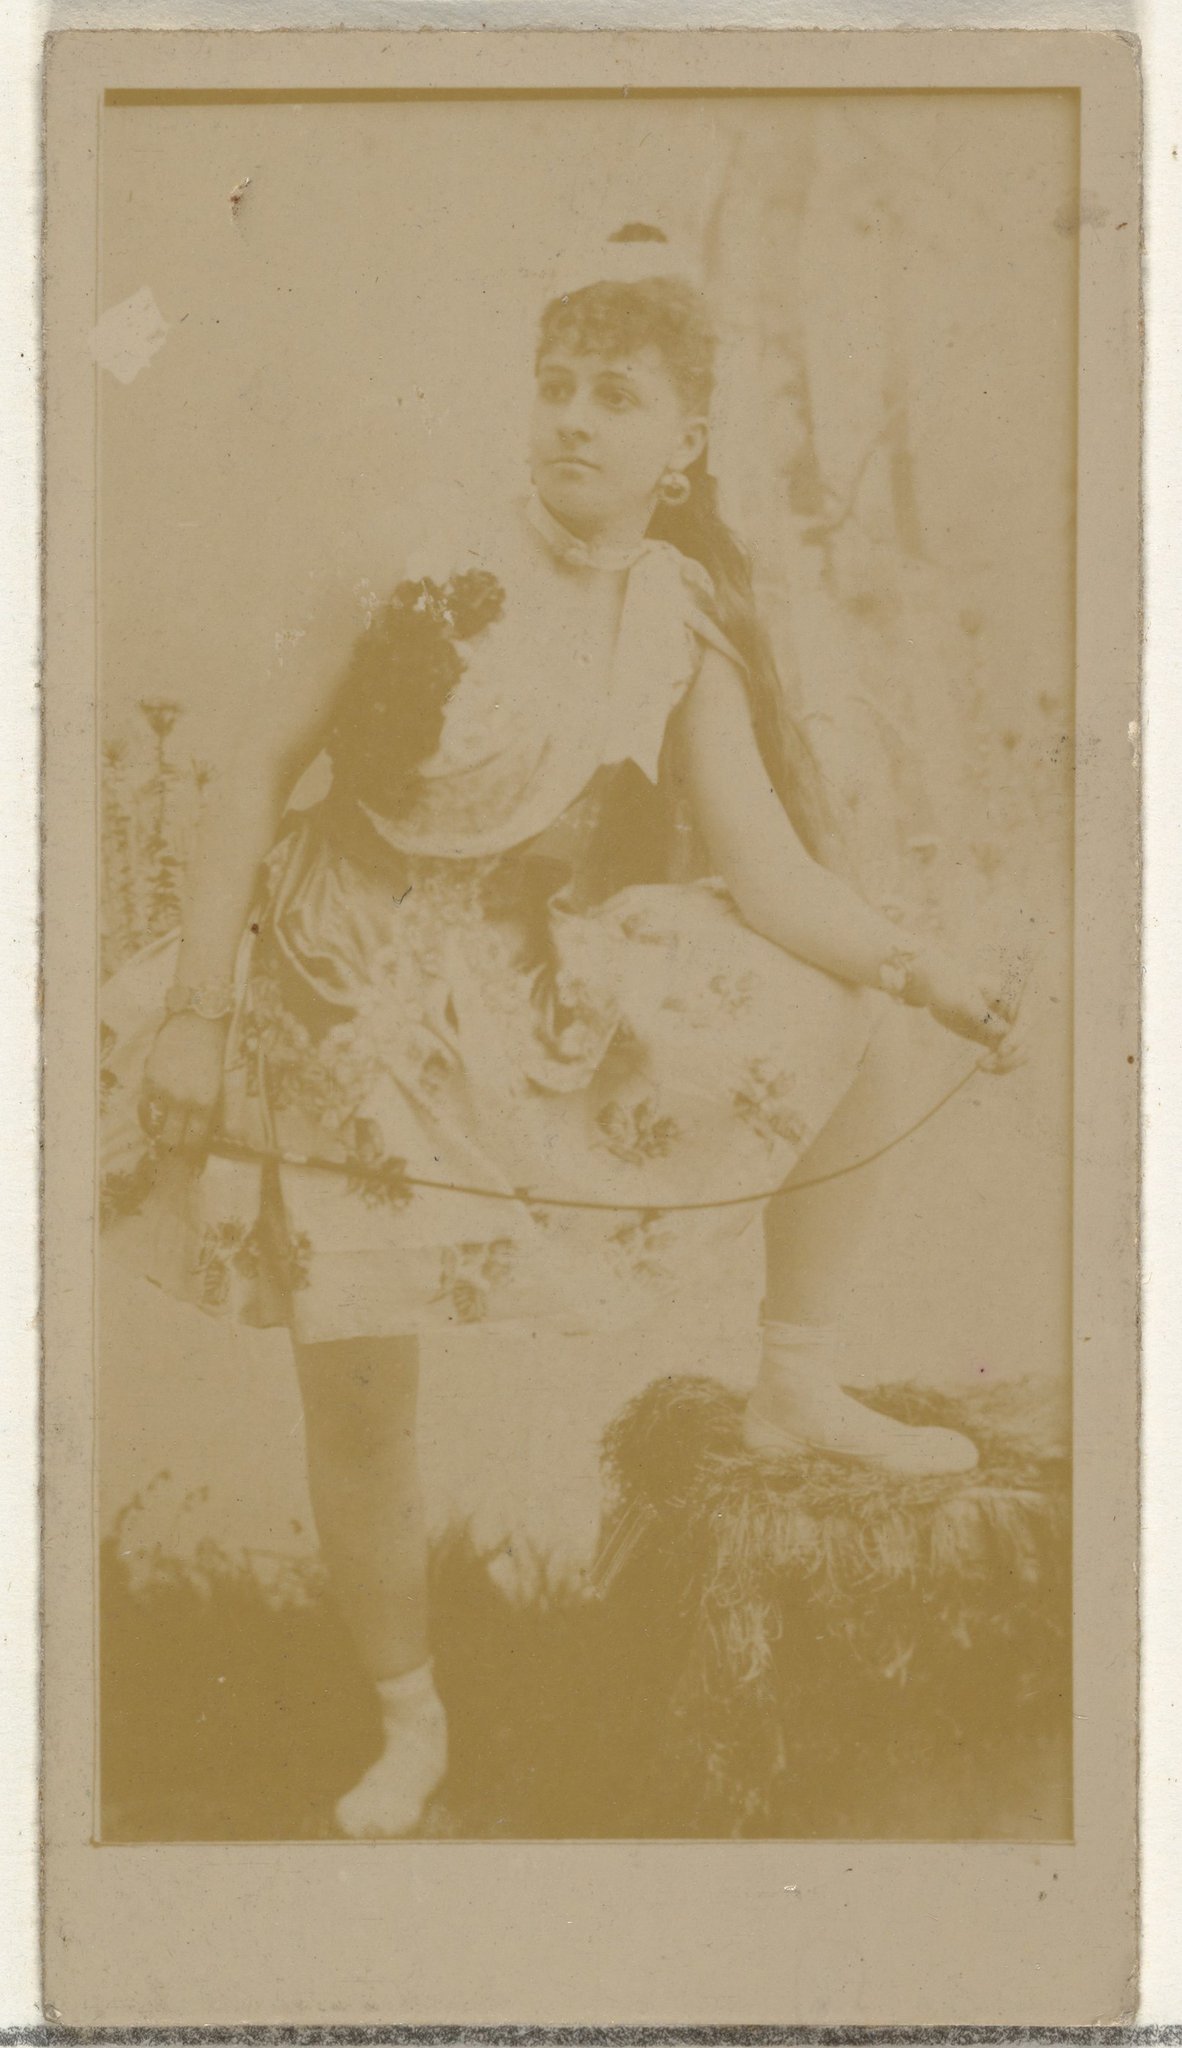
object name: photograph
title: [Actress posing with foot on stool], from the Actors and Actresses series (N145-8) issued by Duke Sons & Co. to promote Duke Cigarettes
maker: w. duke, sons & co.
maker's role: publisher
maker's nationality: american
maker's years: 1870-1920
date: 1891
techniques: albumen silver print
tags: portraits,women,actresses